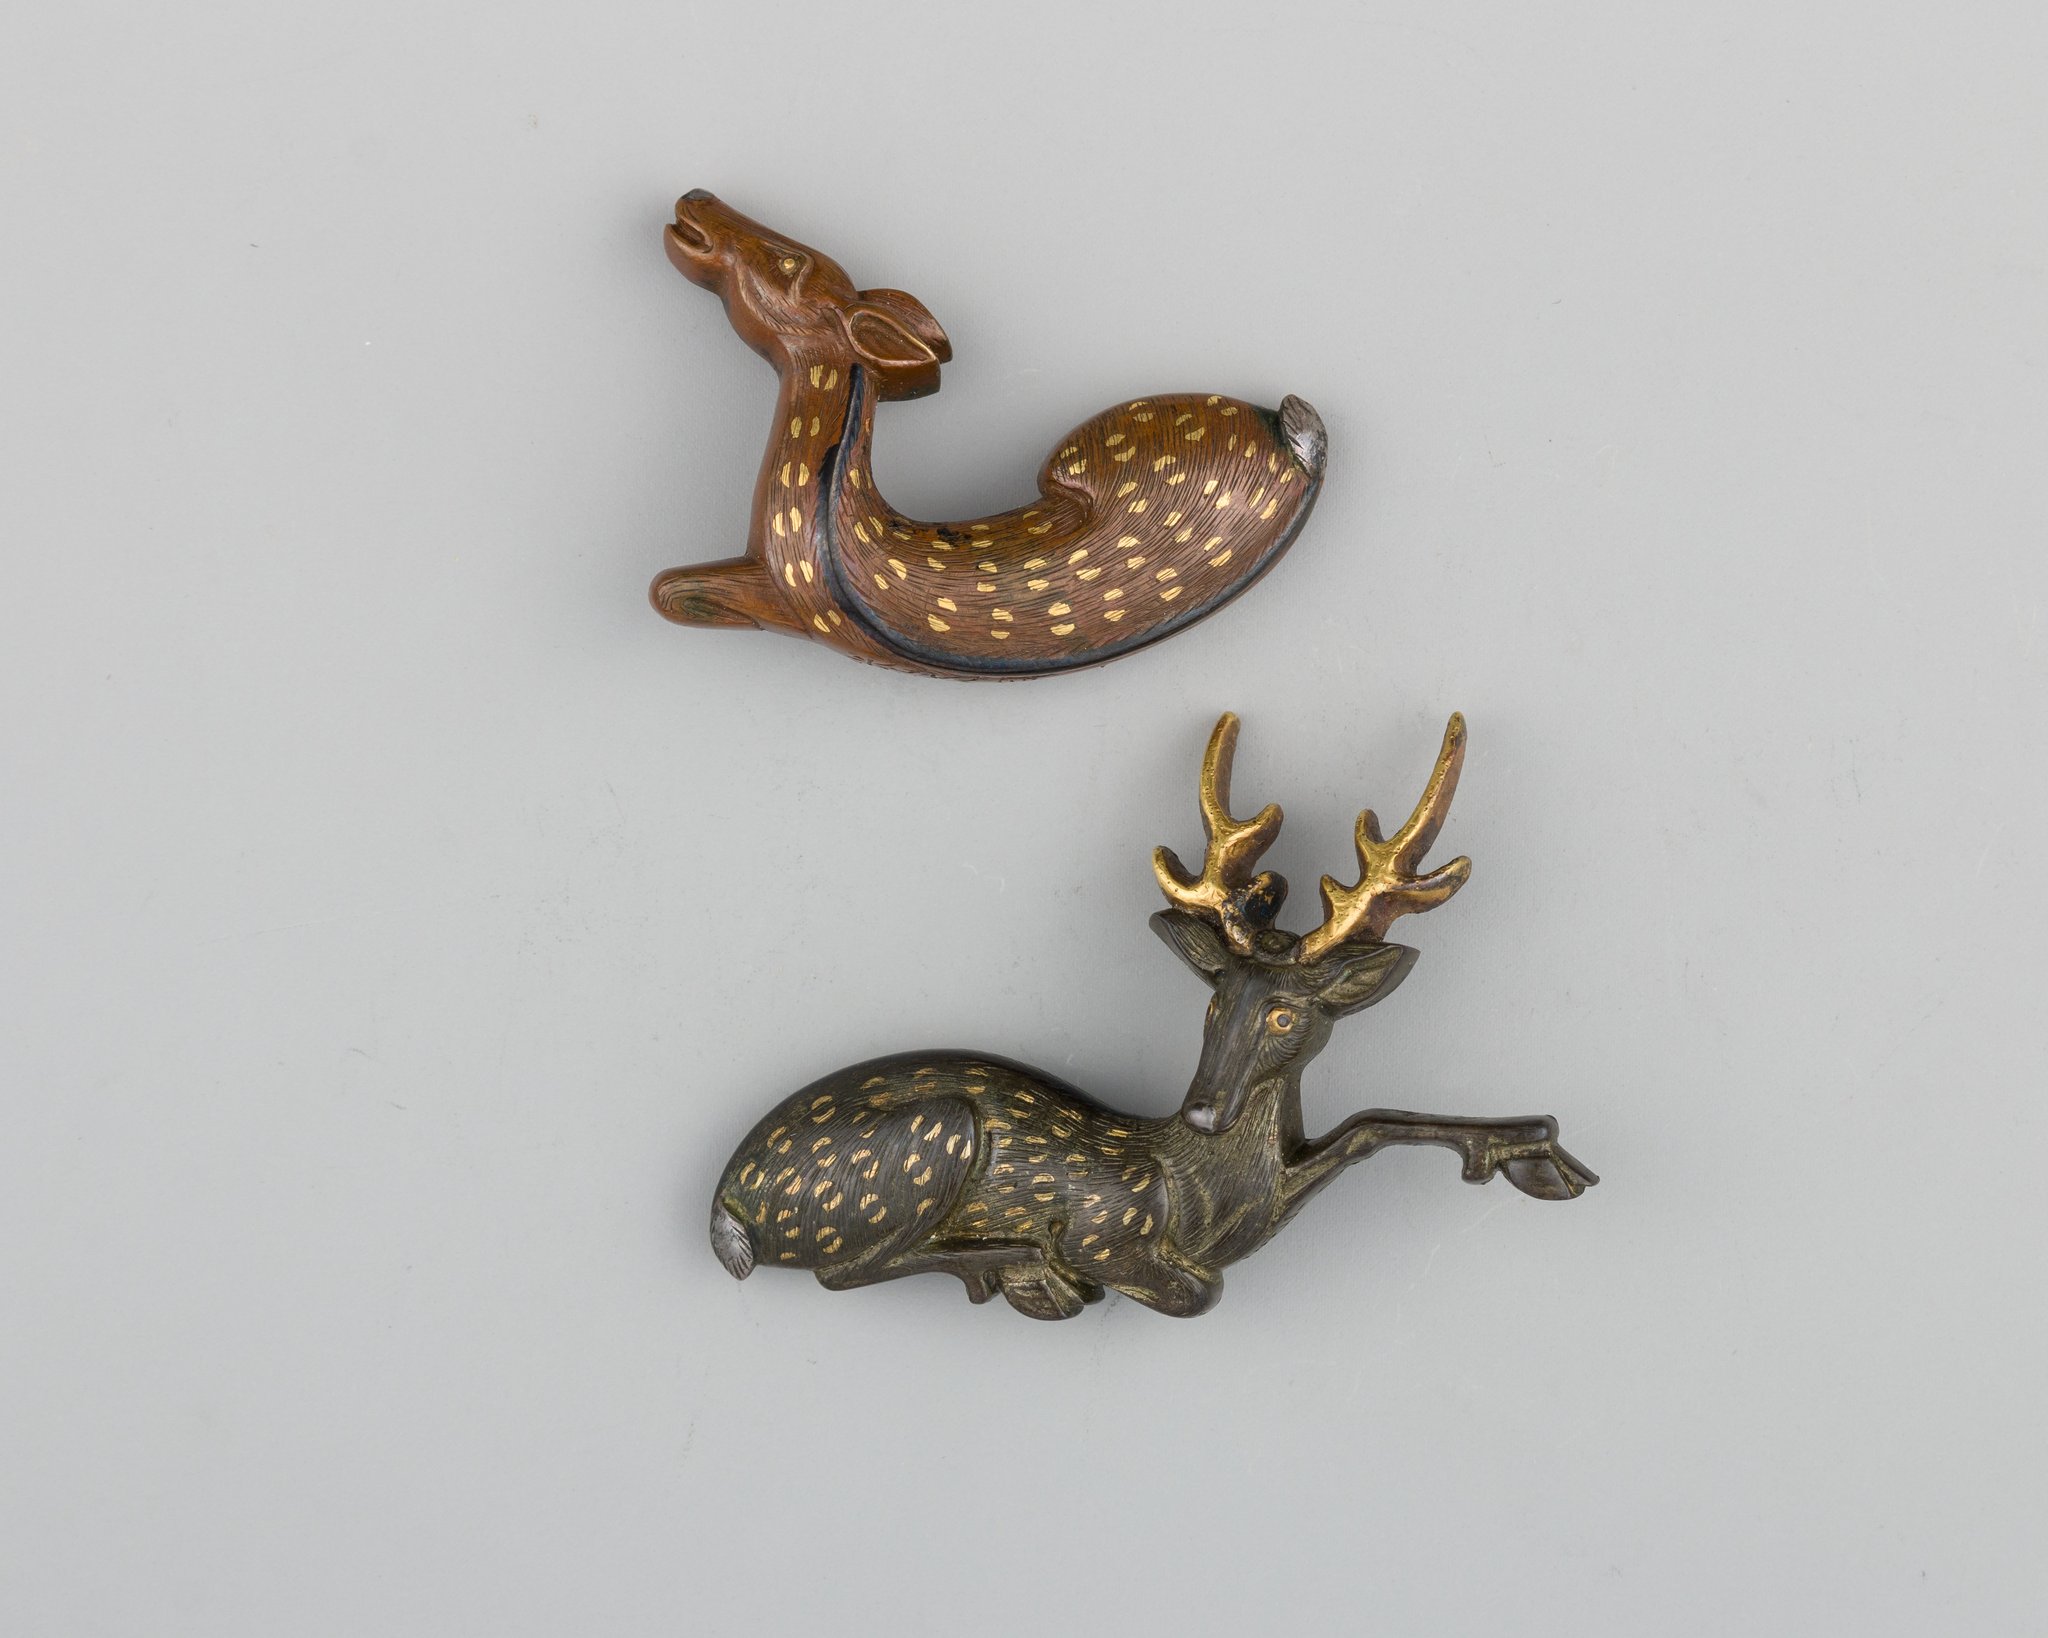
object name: pair of sword grip ornament menuki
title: Pair of Sword-Grip Ornaments (Menuki)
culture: japanese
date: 1801-1900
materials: copper, gold alloy, silver alloy, gold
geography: japan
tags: deer